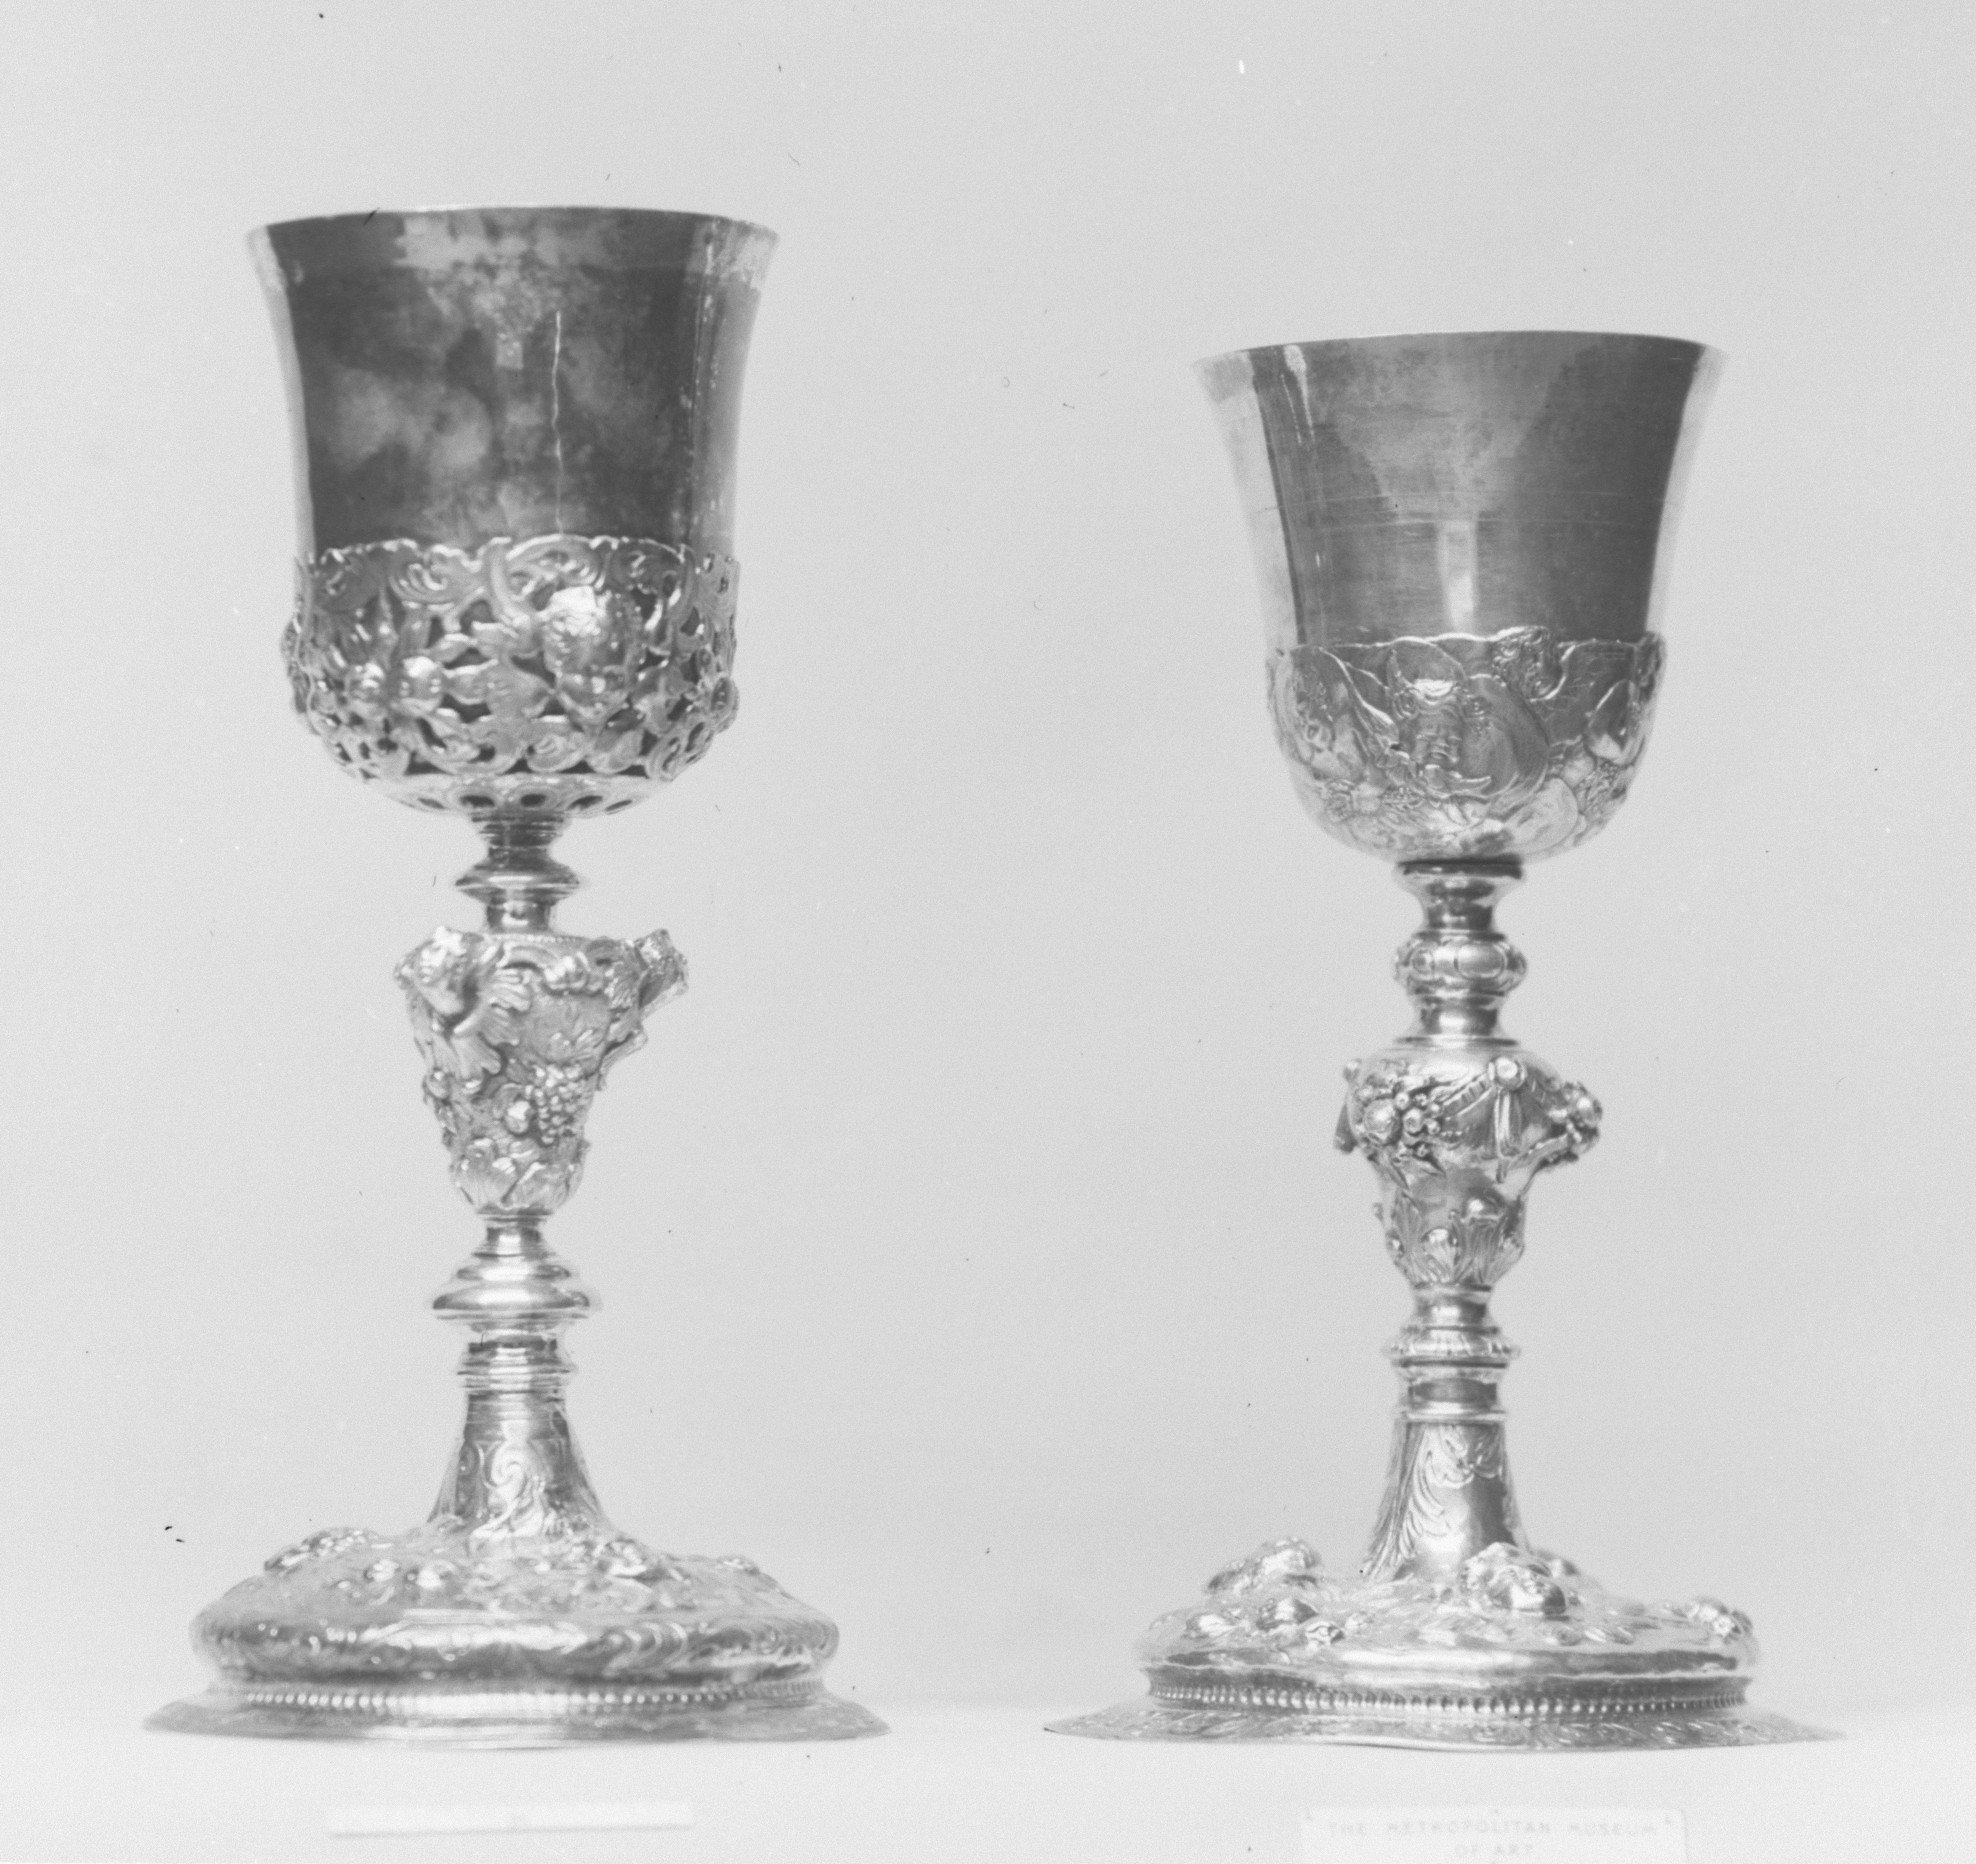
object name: chalice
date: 1701-1800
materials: silver